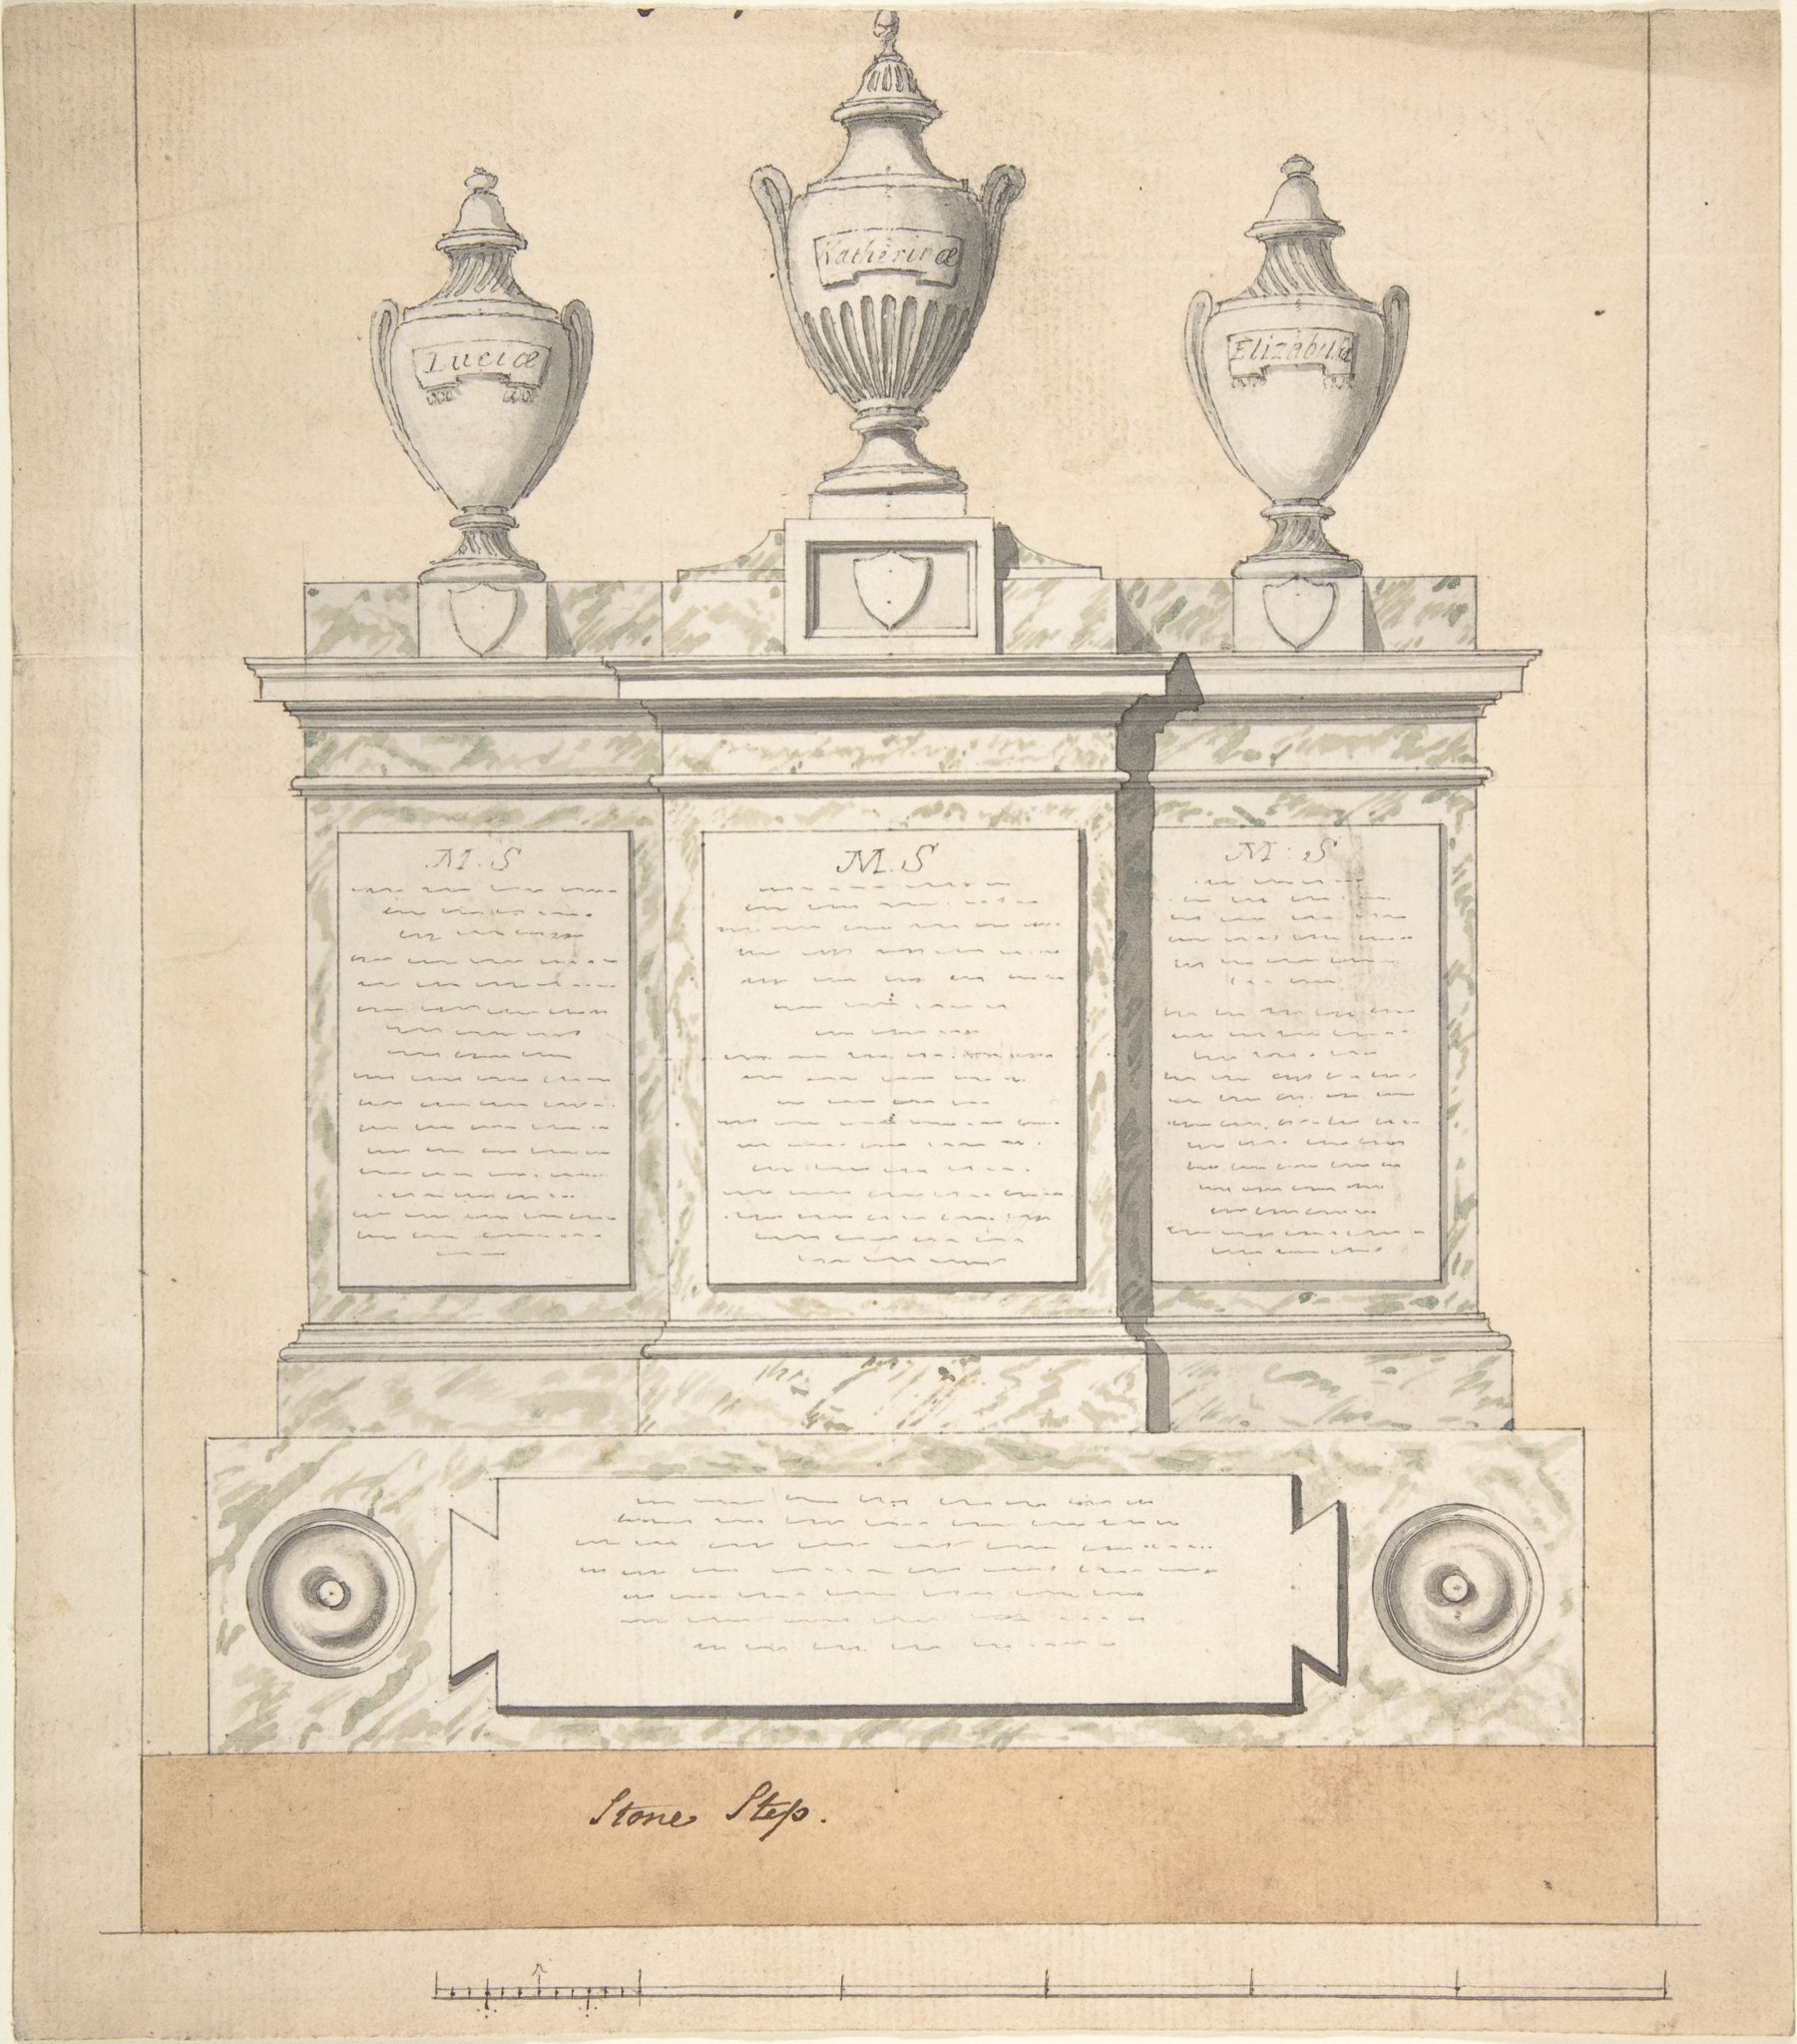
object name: drawing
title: Design for a Monument to the Three Wives of the First Earl of Guilford, at Wroxton, Oxfordshire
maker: joseph wilton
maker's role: artist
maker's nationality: british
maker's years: 1722-1803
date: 1783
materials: ink, watercolor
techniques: brush, pen, wash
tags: monuments